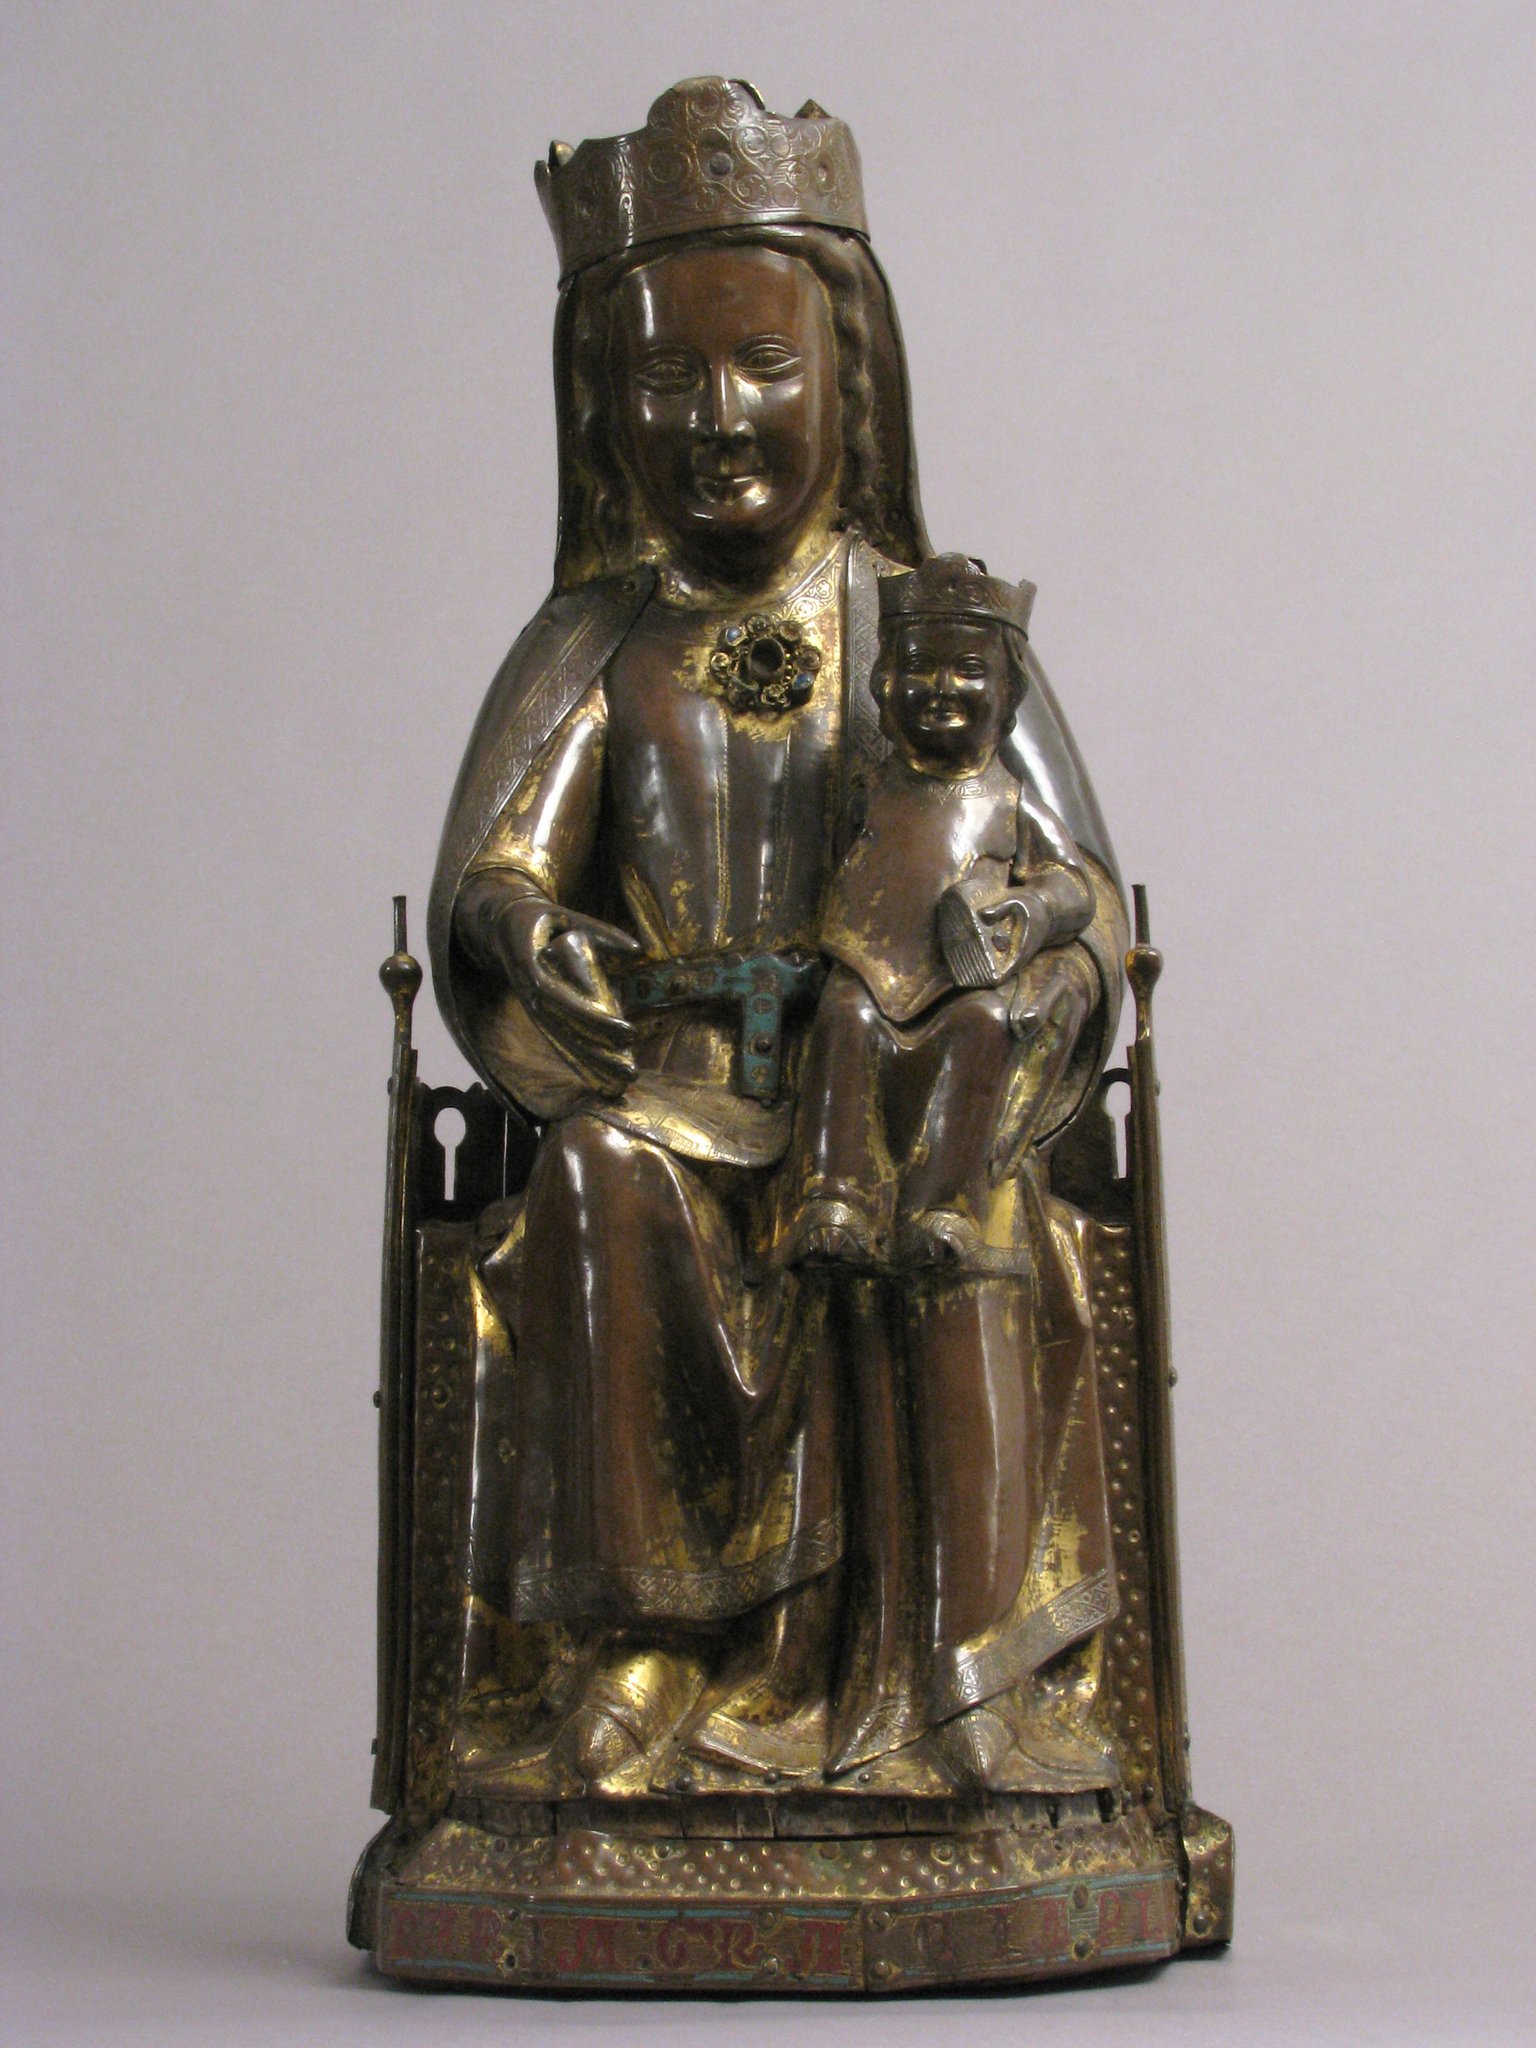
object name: statuette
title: Virgin and Child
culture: french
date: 1270-1300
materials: copper, enamel, gilt, wood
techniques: enamel, cutting, engraving, repoussé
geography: france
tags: saint peter